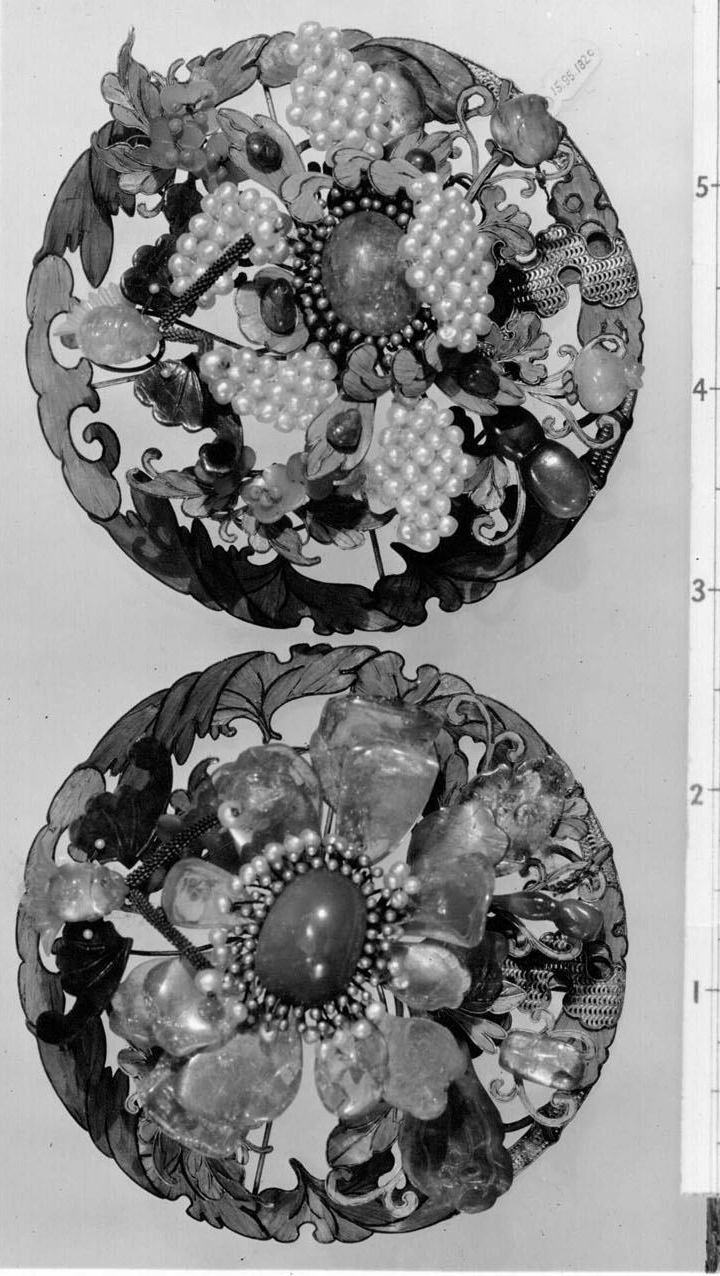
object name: headdress ornament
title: Ornaments for a Headdress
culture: chinese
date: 1701-1900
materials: feather, glass, gold, metal, stone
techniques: gilding